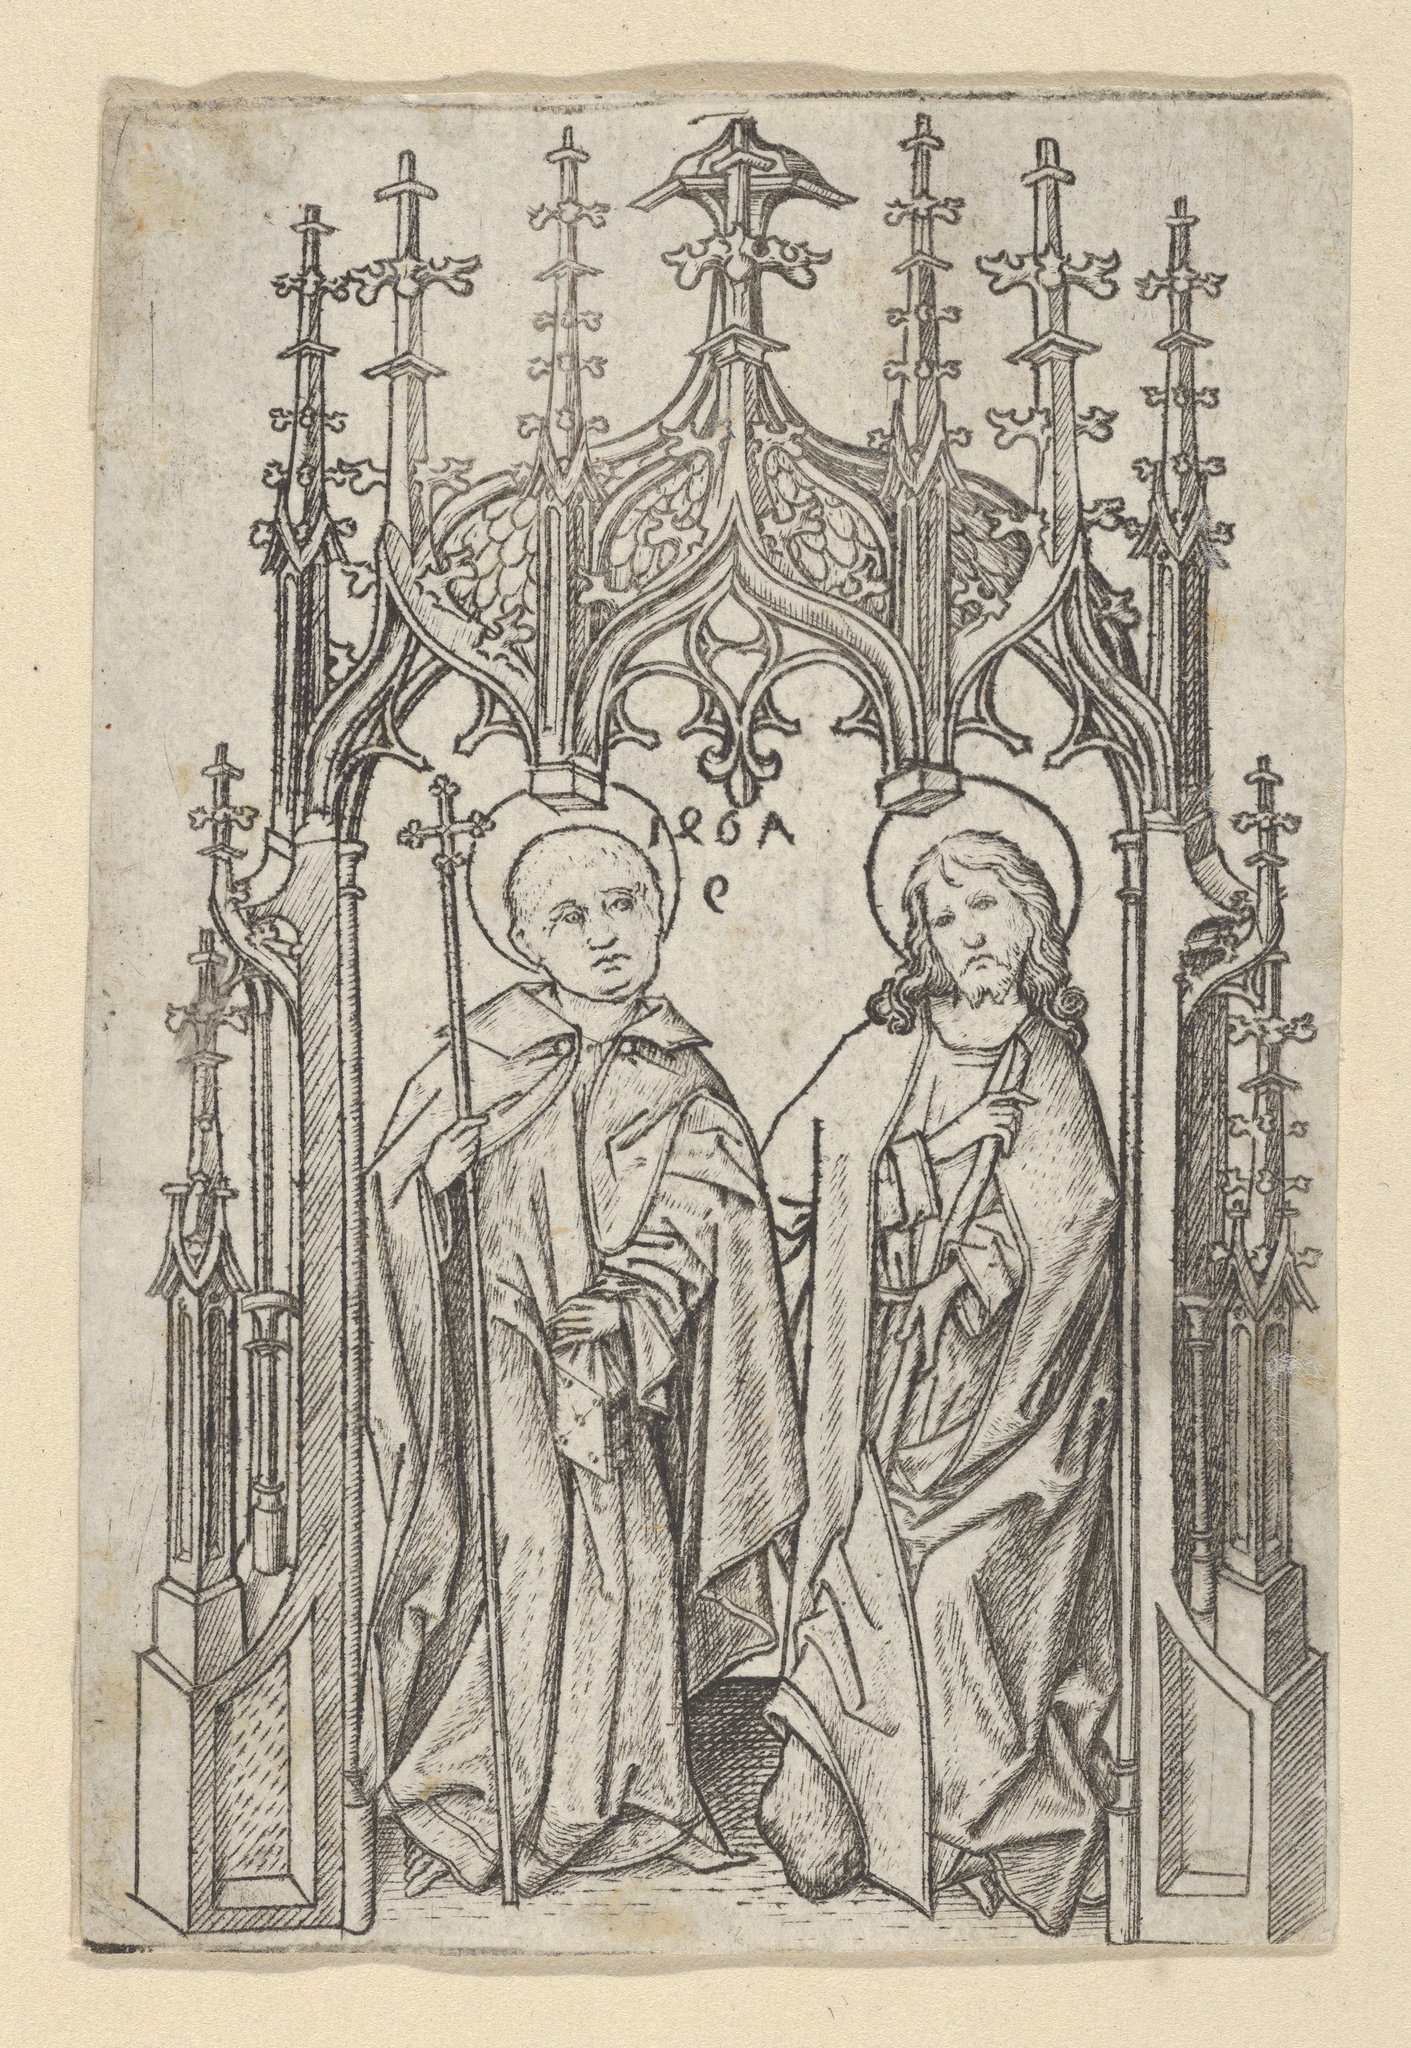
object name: print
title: St. Philip and St. James the Less, from the series The Apostles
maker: master es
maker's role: artist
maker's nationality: german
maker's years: 1445-1467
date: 1401-1500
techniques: engraving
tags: cross,saints